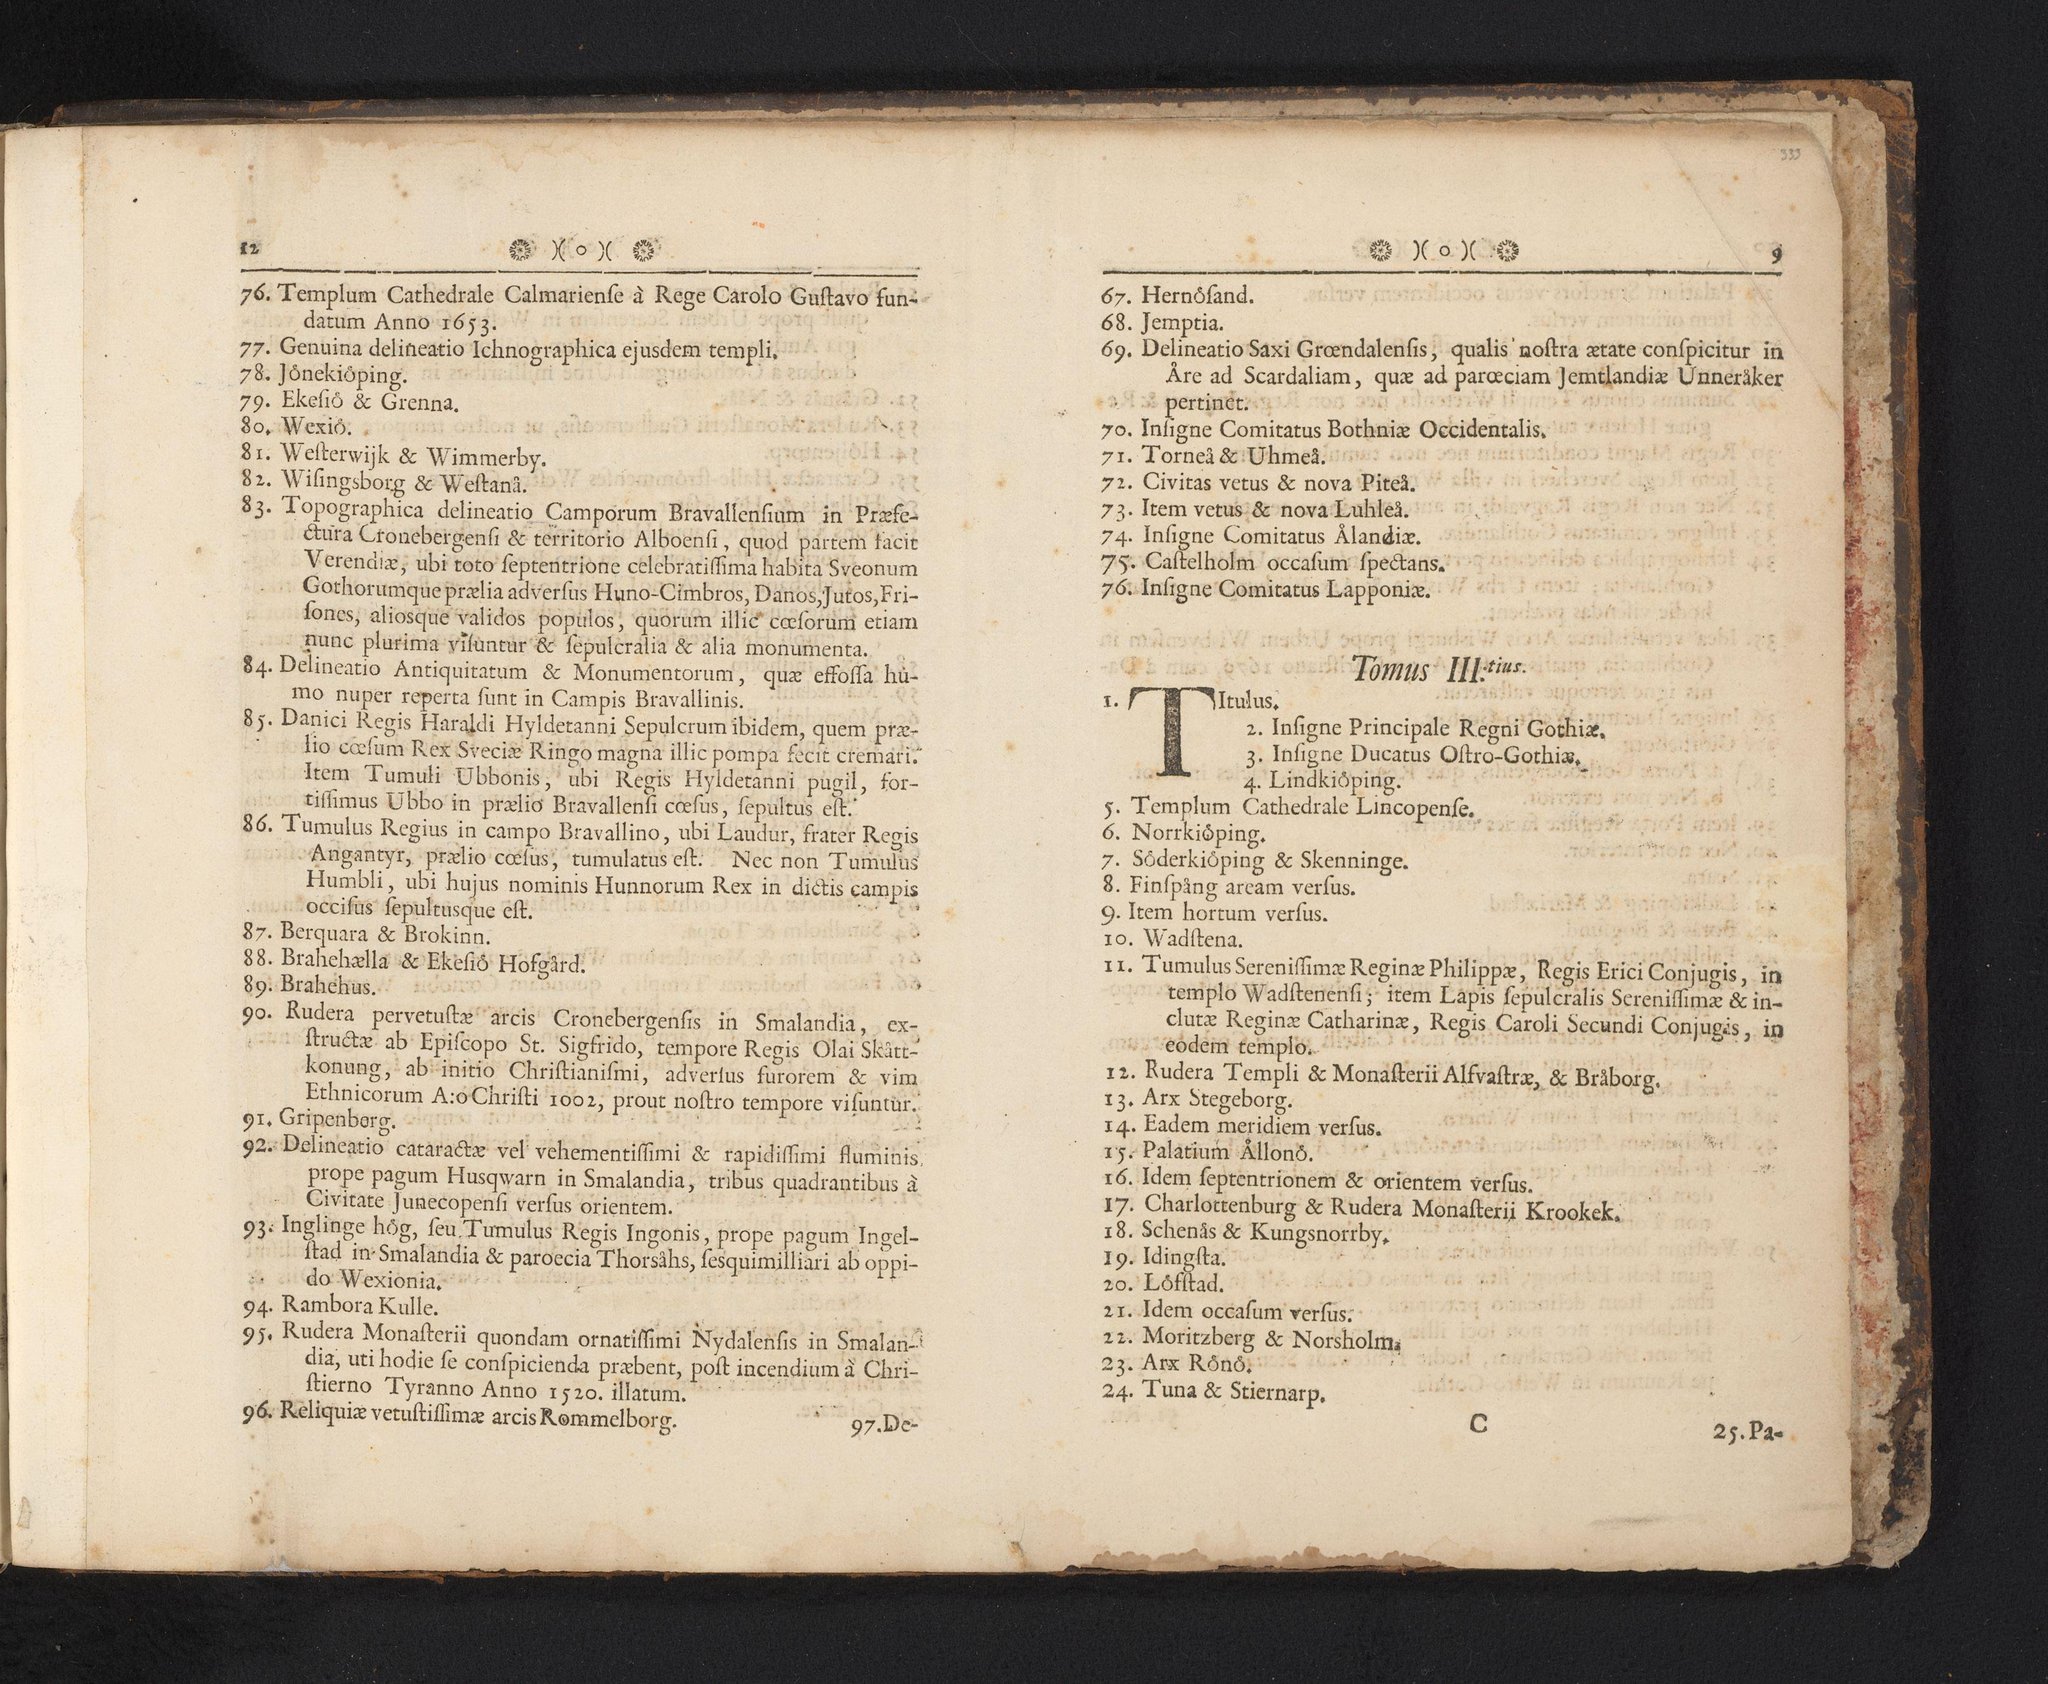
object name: text sheet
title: Index op de prenten, pagina 12 en 9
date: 1661-1715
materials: paper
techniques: letterpress printing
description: Kungliga Biblioteket, 'Suecia': http://www.kb.se/samlingarna/Kartor-bilder/Suecia-antiqua/ (geraadpleegd november 2016).